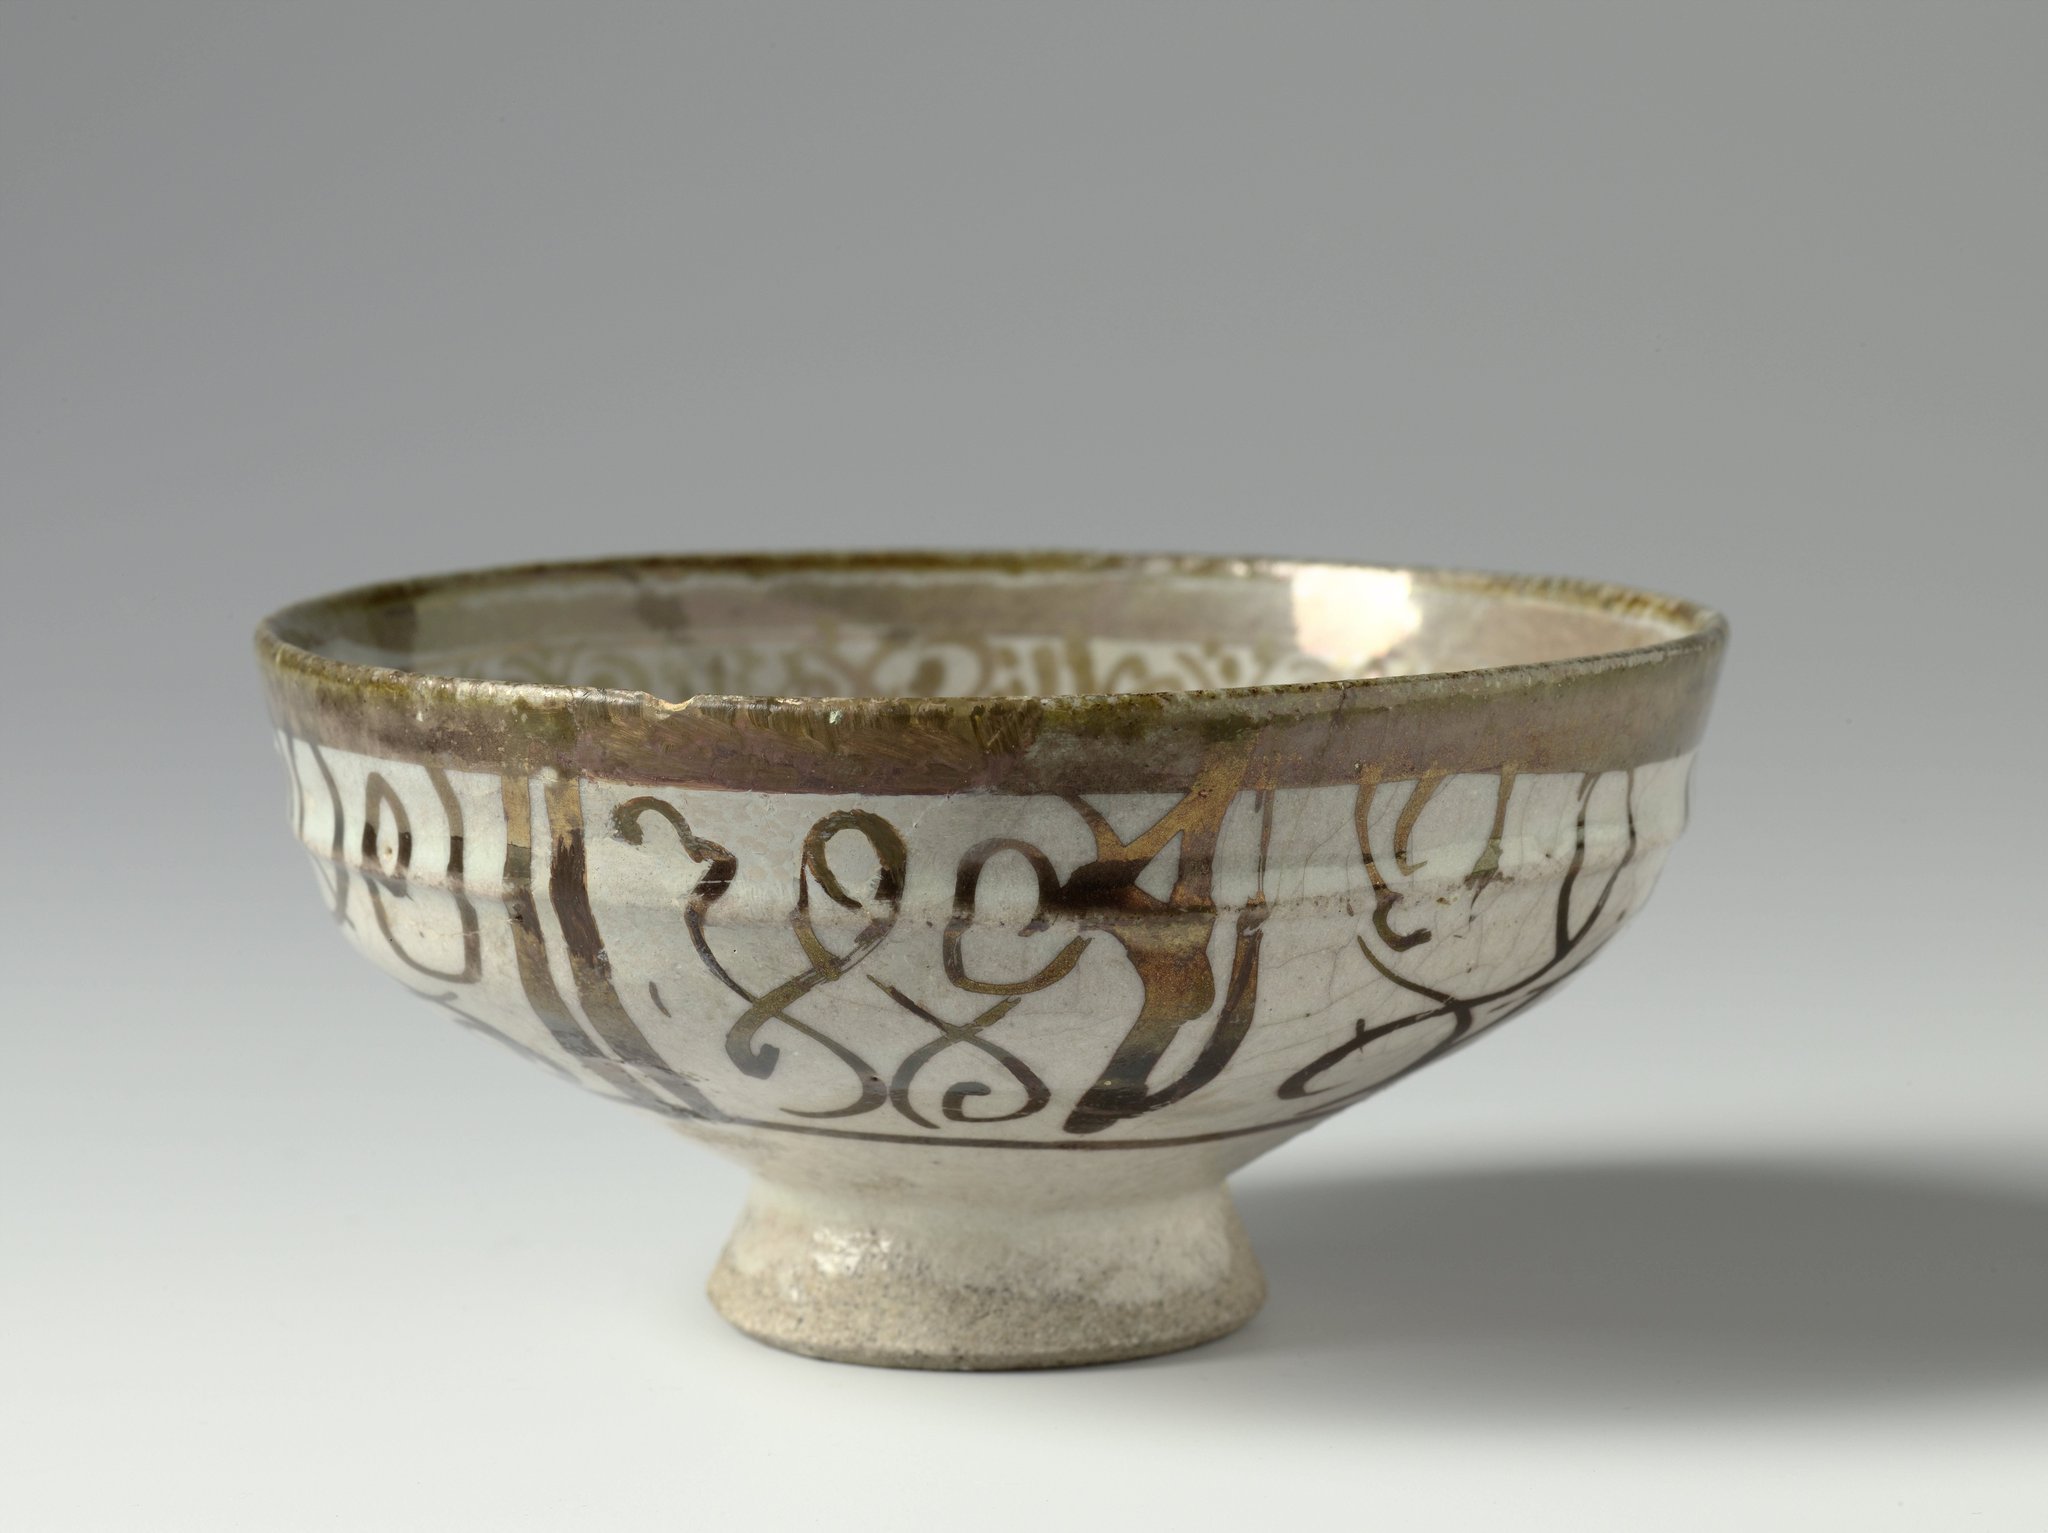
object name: bowl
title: Bowl with scrolls and waving lines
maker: Anonymous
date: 1170-1199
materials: earthenware, glaze, luster, paint, quartz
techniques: firing, turning, vitrification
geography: kashan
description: Kom van kwarts-fritgoed op hoge voet gedecoreerd met geometrische en florale motieven in luster op ondergrond van opaak wit tin-lood-alkaliglazuur. Op de binnenzijde een medaillon verdeeld in acht vakken met afwisselend golvende lijnen en bladranken. De binnenrand met een band met krulwerk in vakken. De buitenzijde is ook verdeeld in vakken, gevuld met krulwerk.